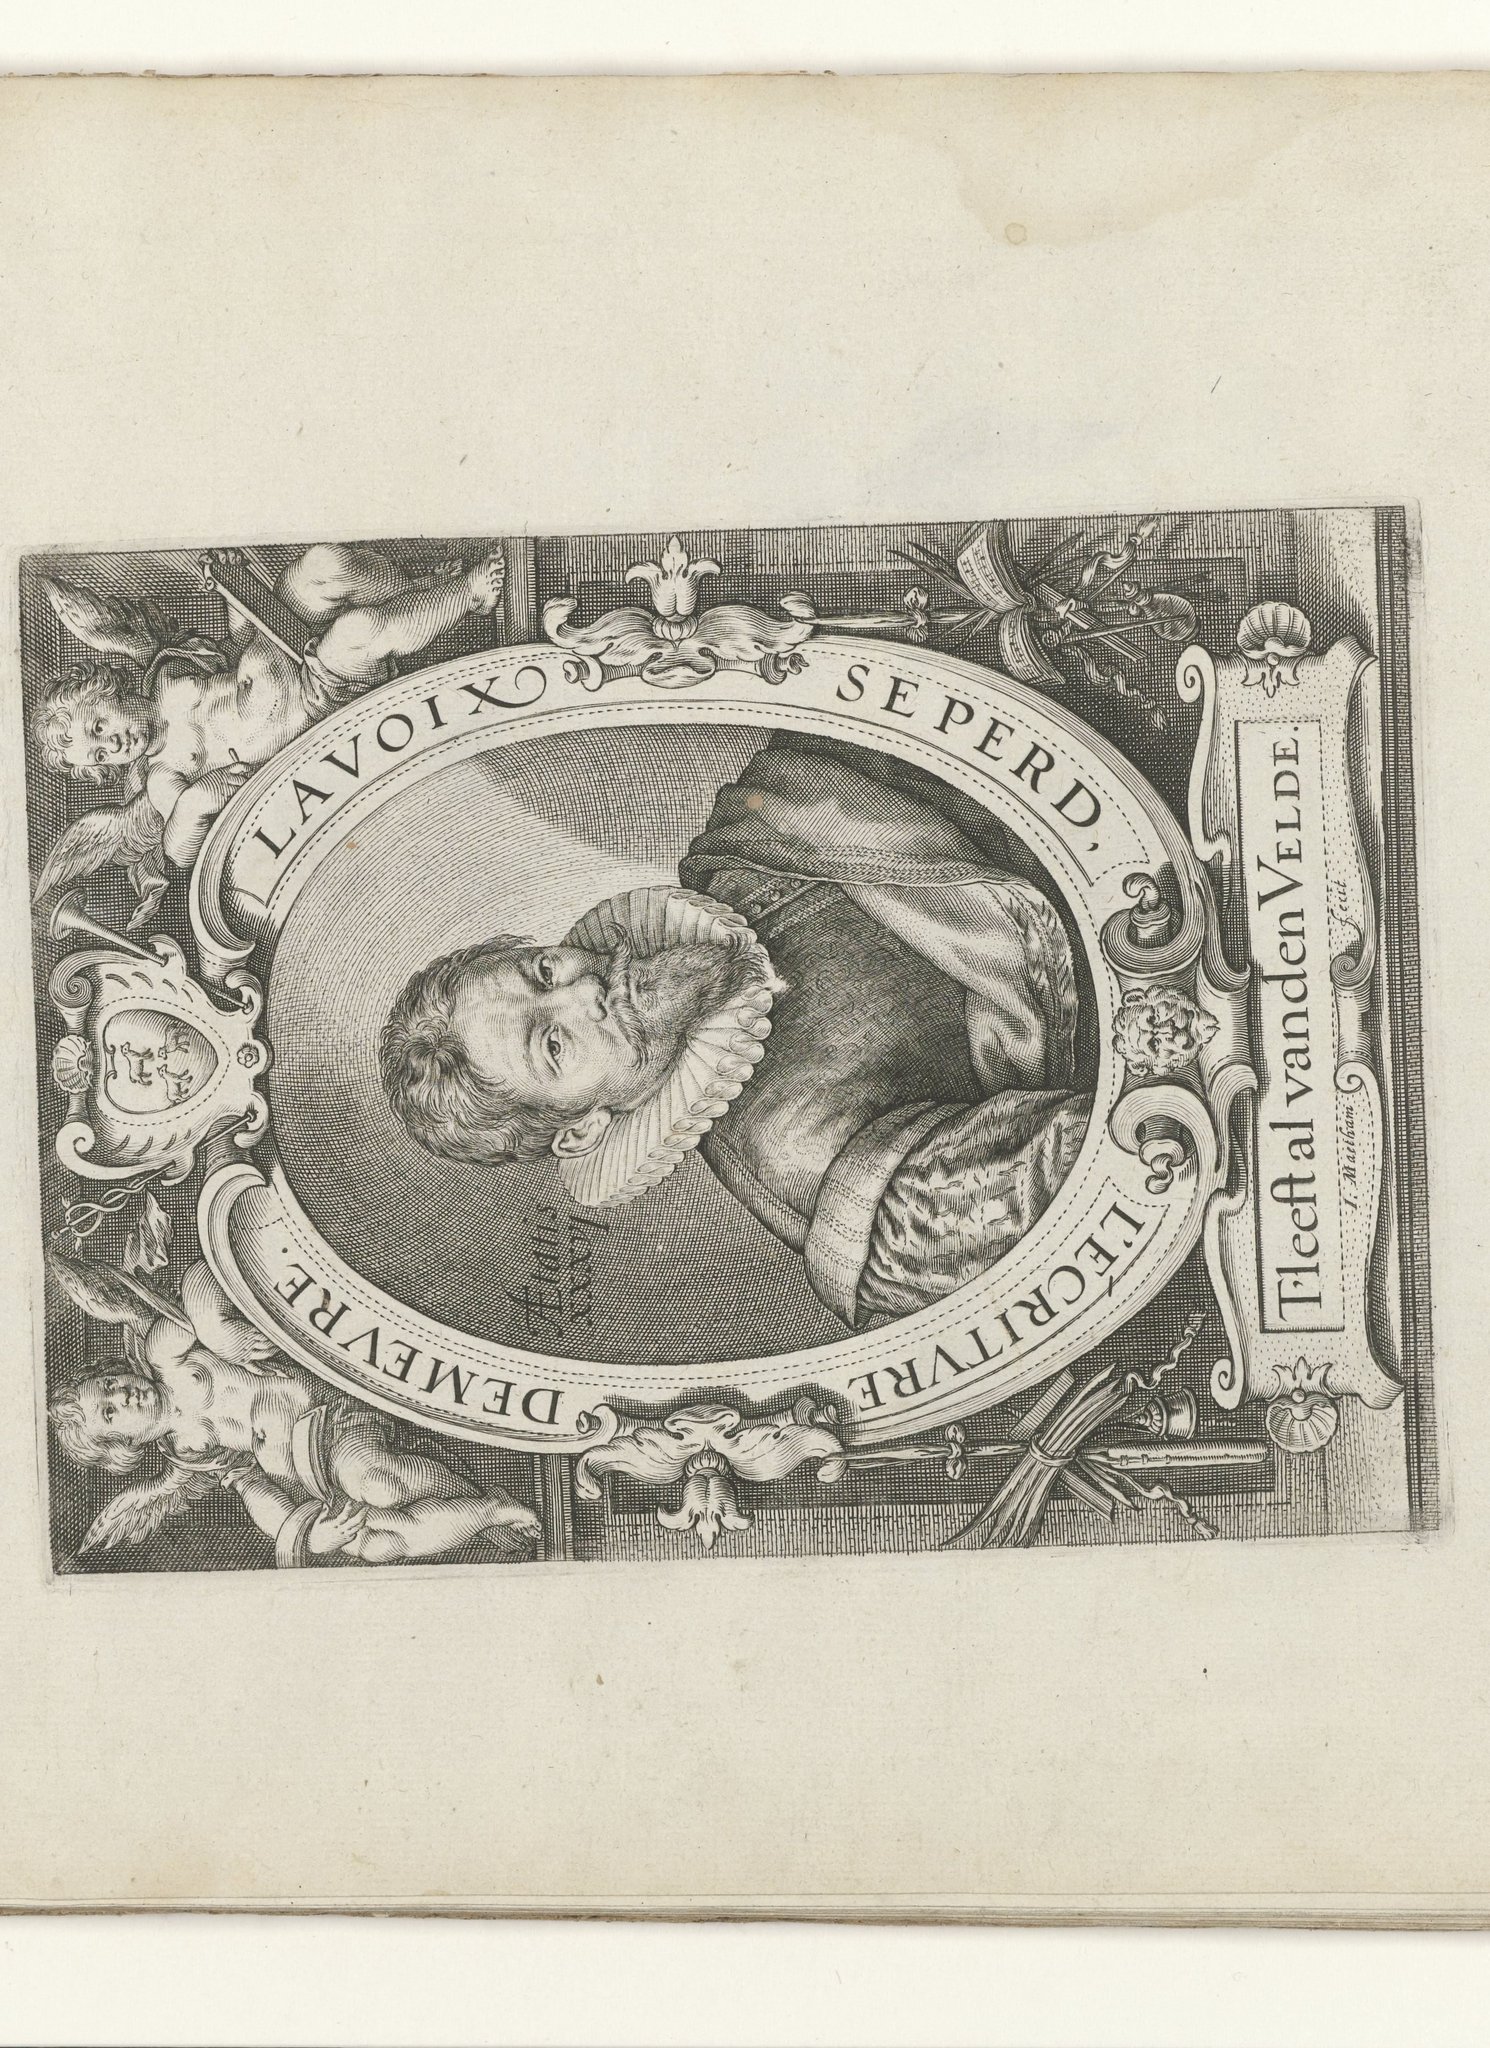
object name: print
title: Spieghel der schrijfkonste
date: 1605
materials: paper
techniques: engraving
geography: amsterdam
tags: painter, jan van de velde (i)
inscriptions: collector's mark: Lugt 2760, collector's mark: Lugt 2228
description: Portret van de kalligraaf Jan van den Velde op 36-jarige leeftijd in een ovale omlijsting met het randschrift: La voix se perd, l'écriture demeure. Bovenaan zijn wapenschild, een veld met drie schapen, en eronder zijn wapenschild: T'leeft al vanden Velde. Daarnaast een caduceus en loftrompet. Links en rechts een putti met schrijfbenodigdheden. De prent maakt deel uit van een album.